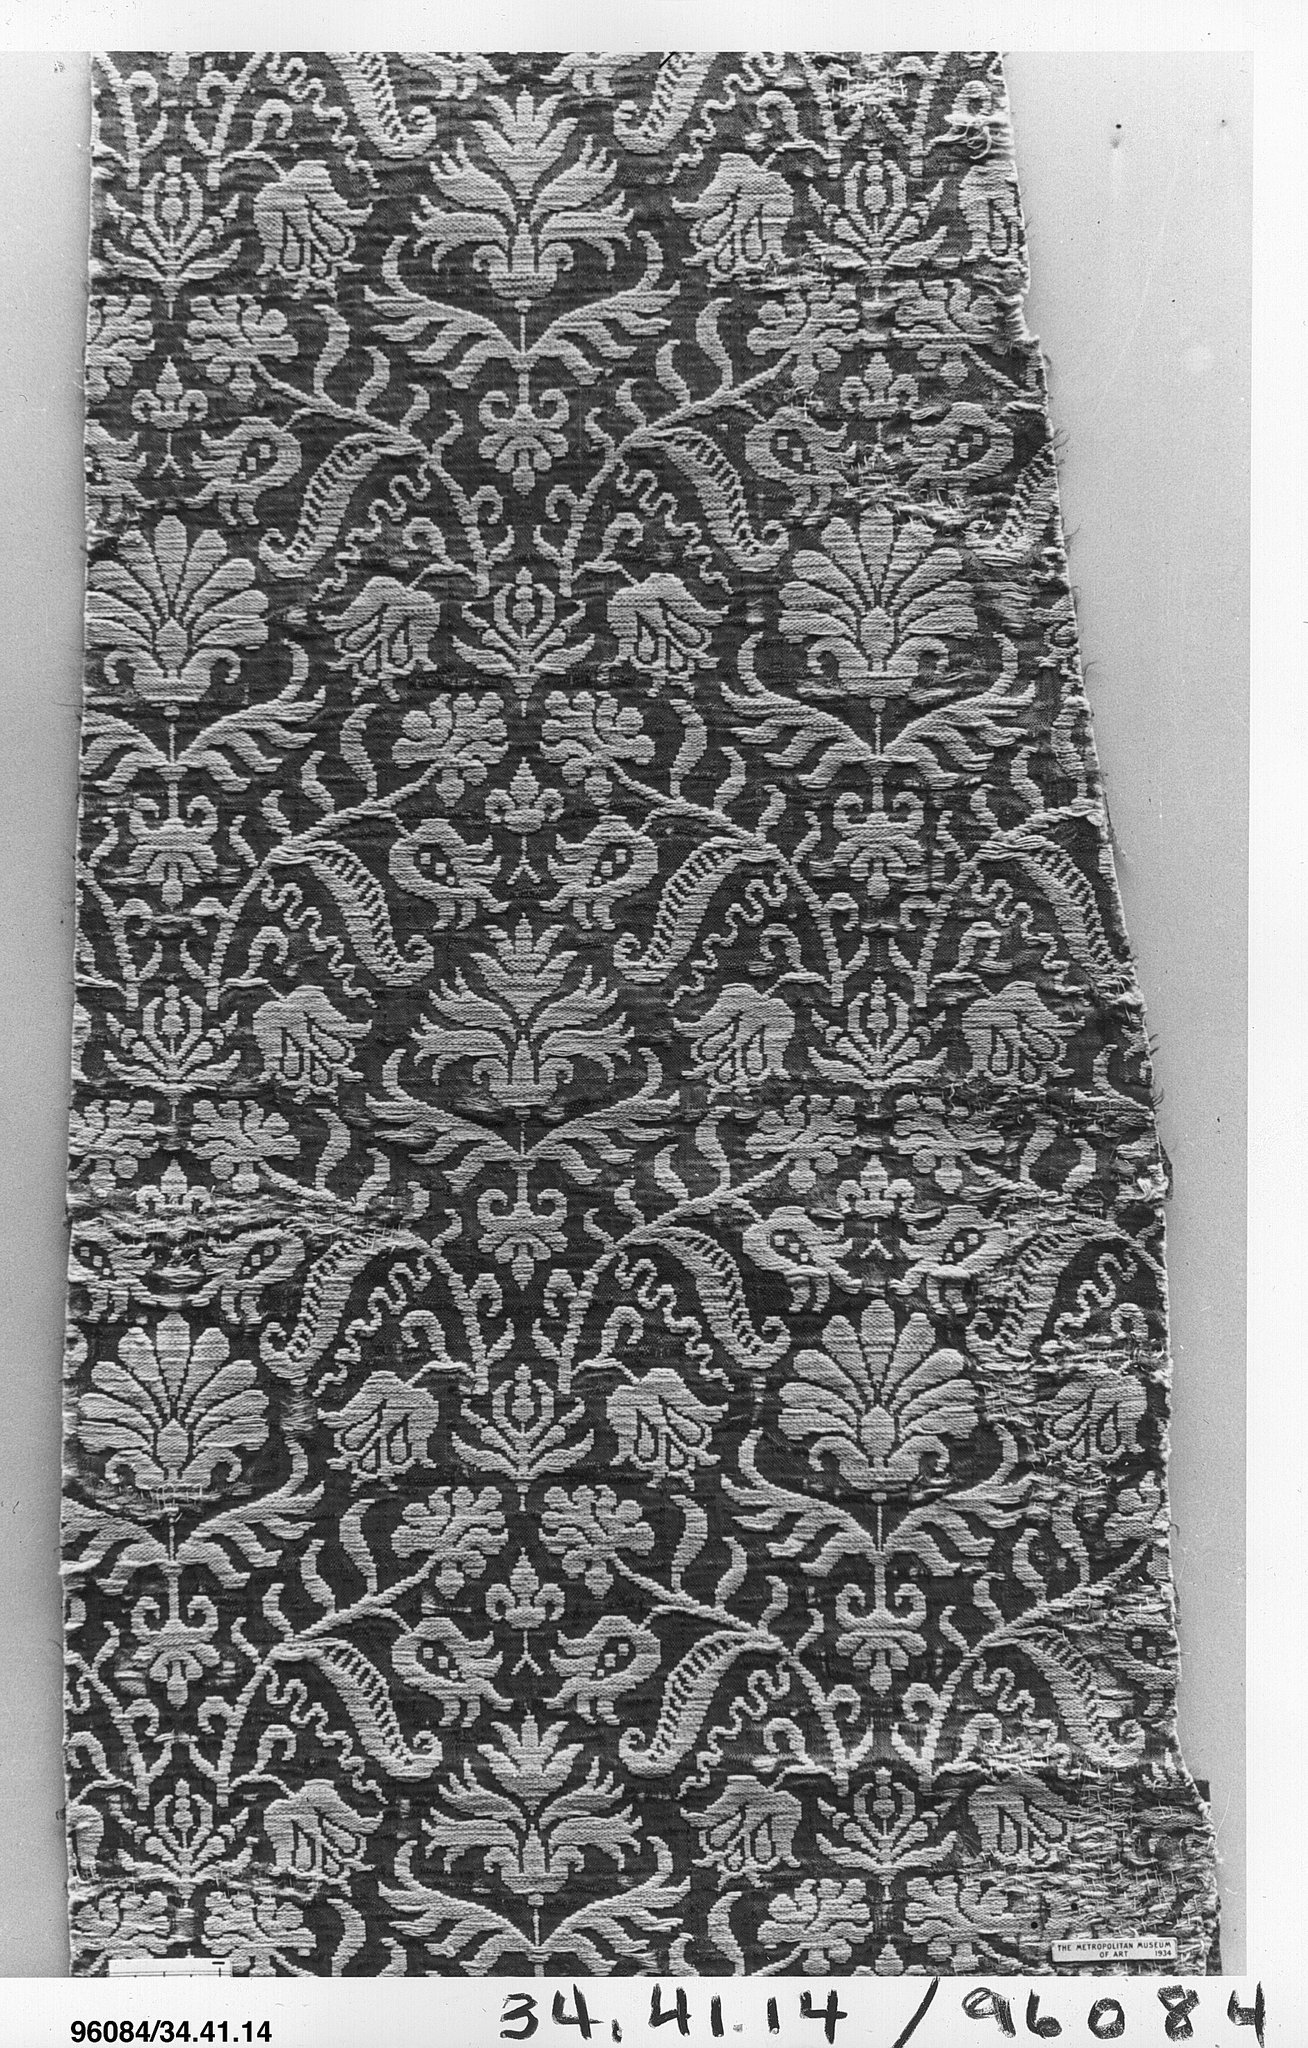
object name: piece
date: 1501-1600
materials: linen, silk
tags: flowers